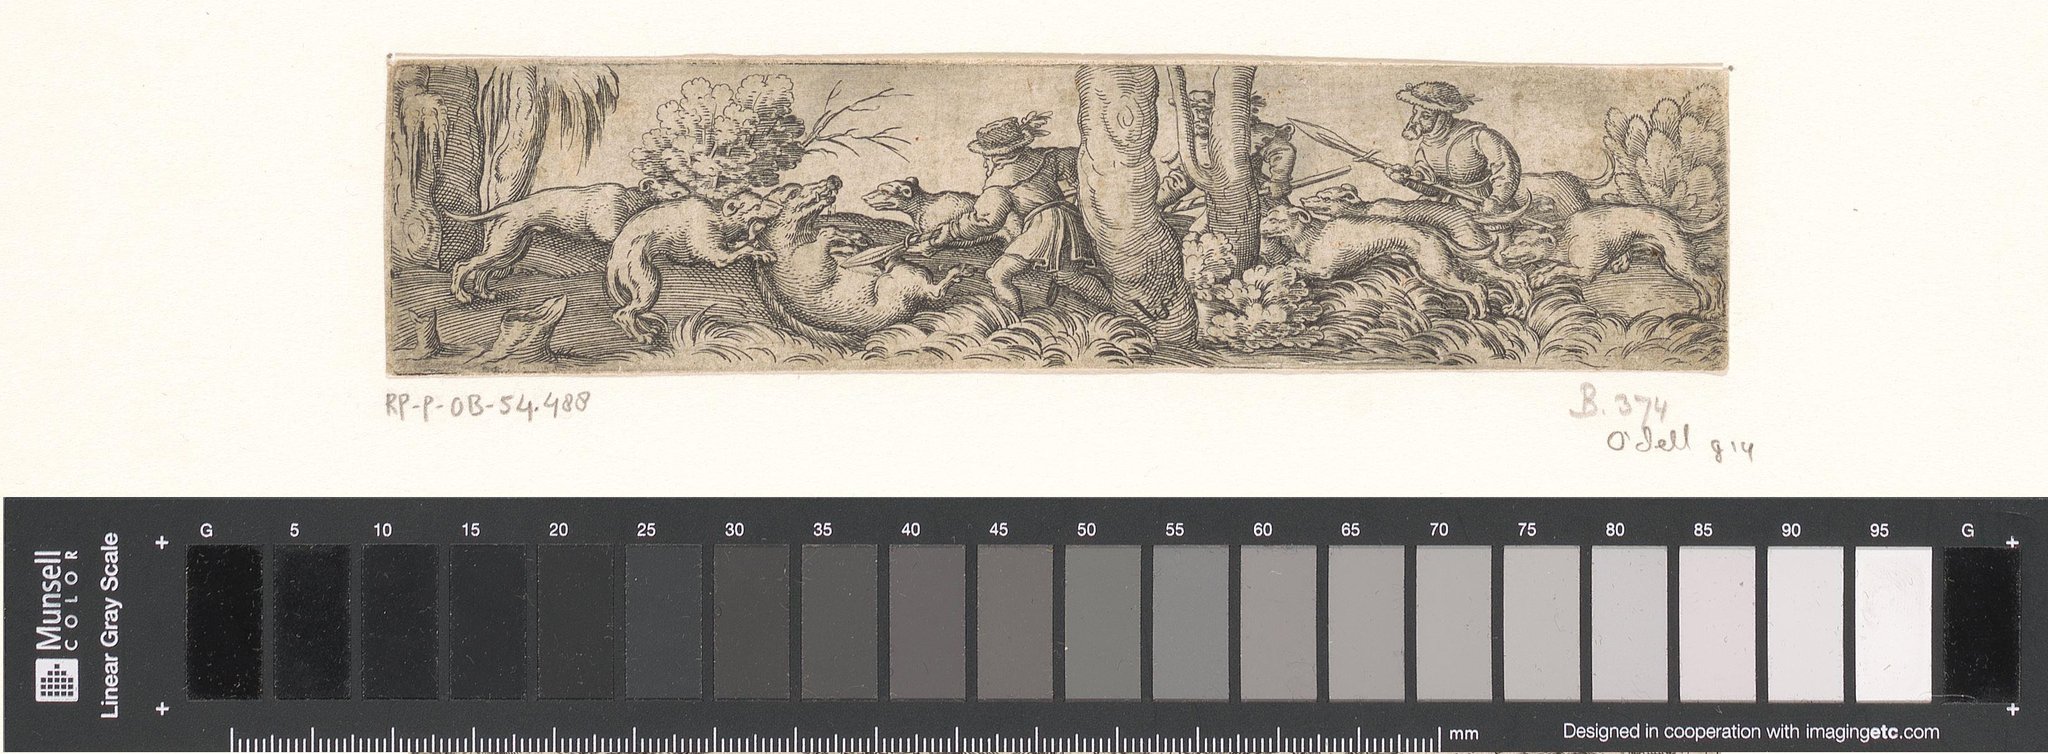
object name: print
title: Wilde zwijnenjacht met drie jagers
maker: virgilius solis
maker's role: draughtsman, print maker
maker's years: 1514-1562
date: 1524-1562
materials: paper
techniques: engraving, intaglio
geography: nuremberg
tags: hunting dogs, boar-hunting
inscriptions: number: ‘32’, collector's mark: Lugt 2228